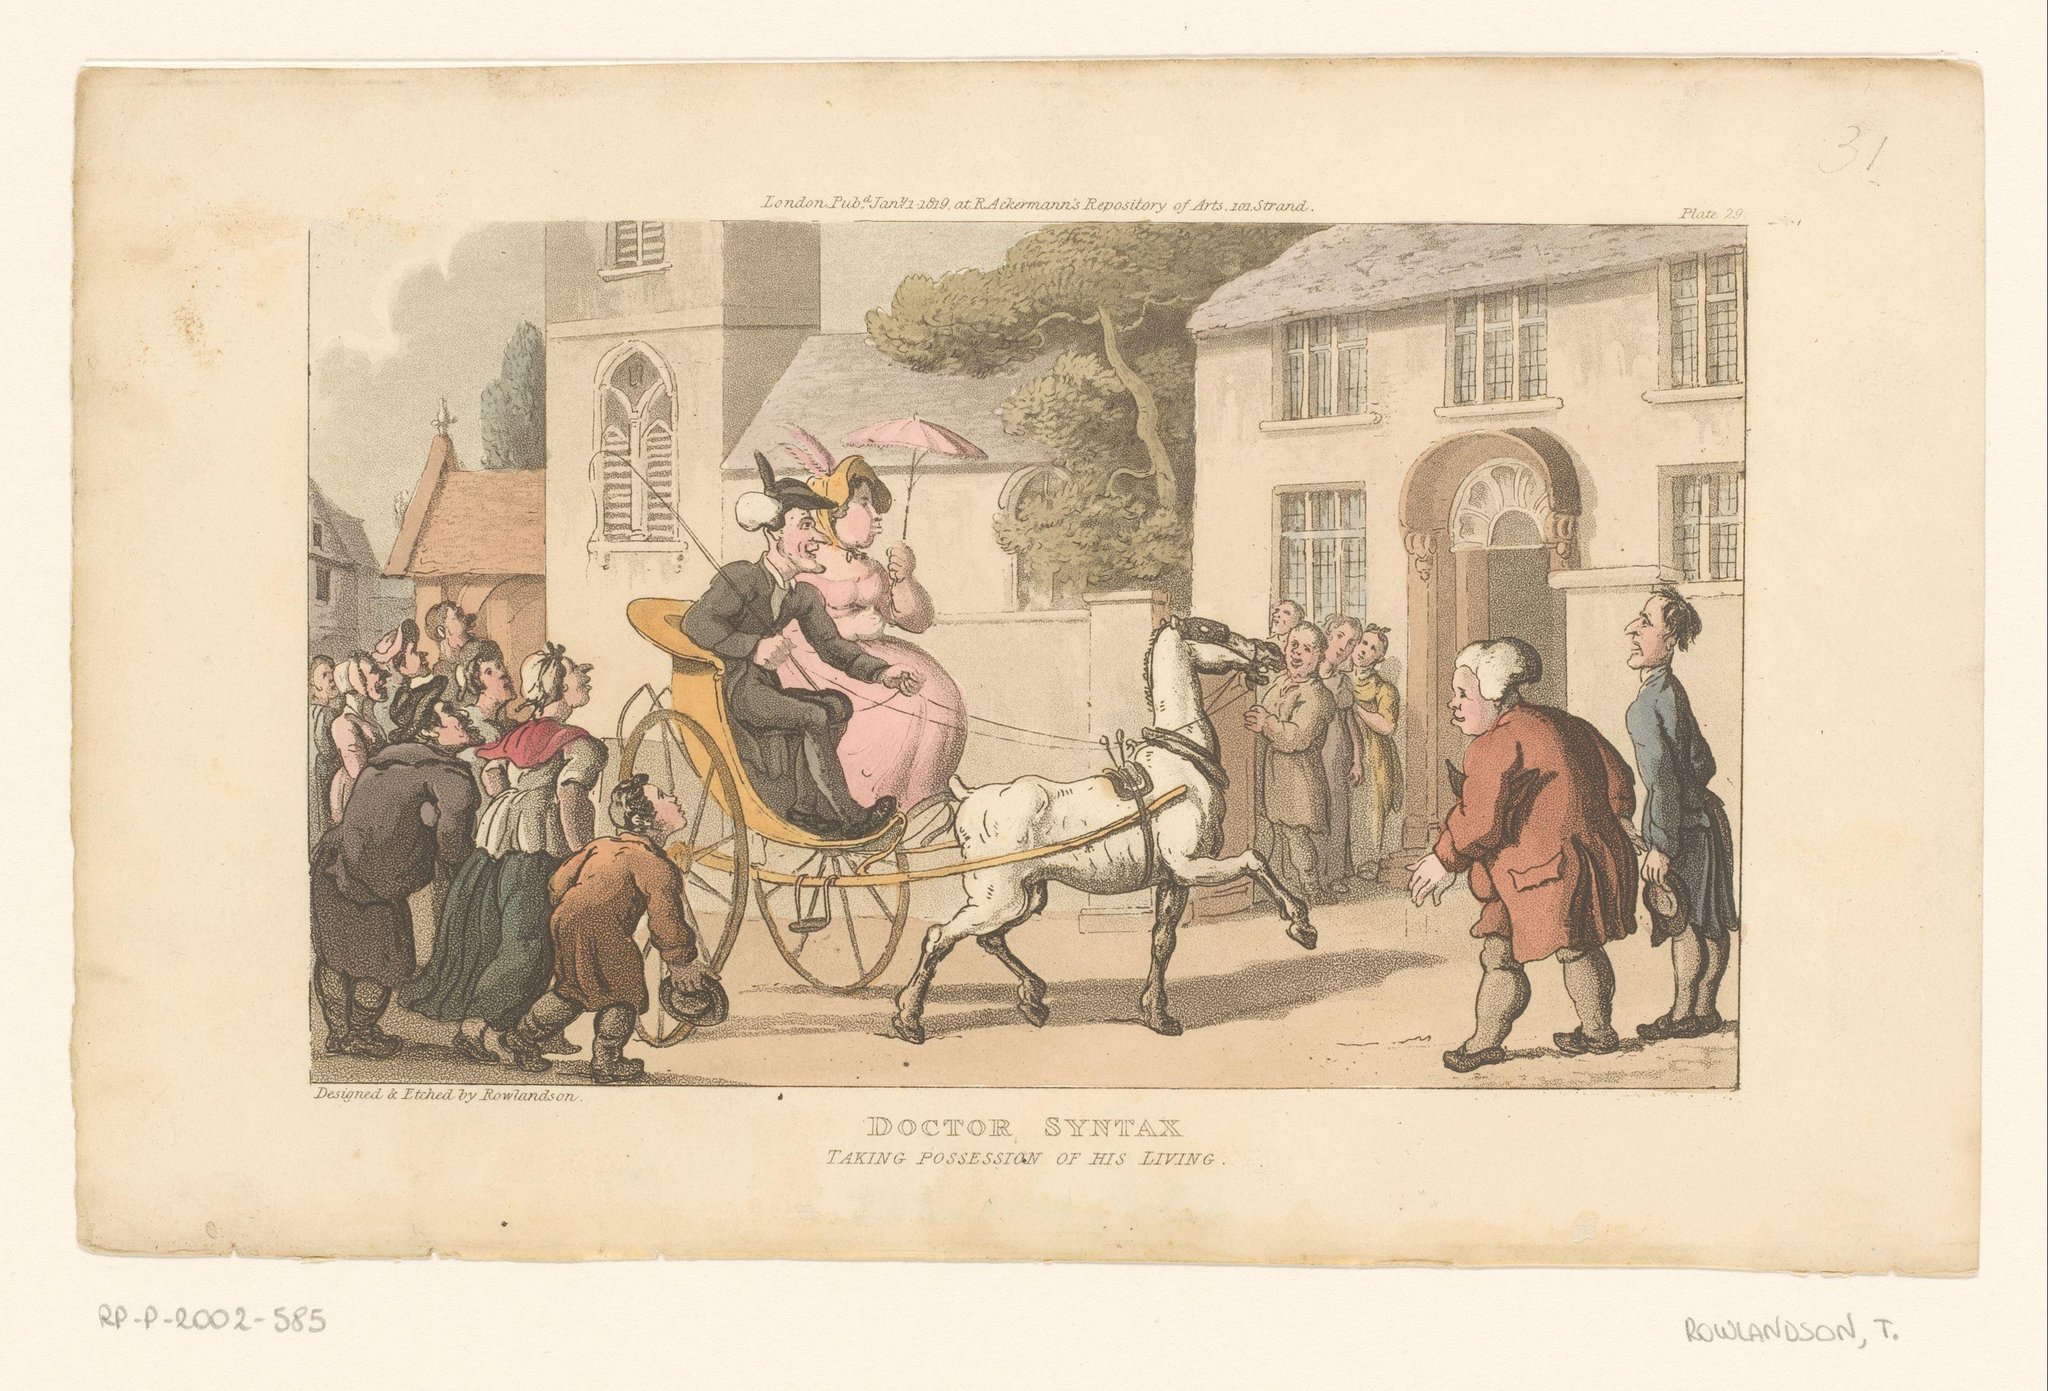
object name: print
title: Doctor Syntax taking possession of his living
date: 1801-1819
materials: paper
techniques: aquatint, etching, hand coloring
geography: london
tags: urban housing, church (exterior), two-wheeled vehicle drawn by one animal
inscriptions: collector's mark: Lugt 2228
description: Prent ook gebruikt in: Combe, William. The Tour of Doctor Syntax, in Search of the Picturesque. A Poem. Londen: Rudolph Ackermann, 1819. Het gedicht is een satire op William Gilpin, die in Groot-Brittannië op zoek ging naar 'het pittoreske'. Het gedicht verscheen voor het eerst met illustraties van Rowlandson in The Poetical Magazine, tussen 1809 en 1811. Voor de editie uit 1819 zijn nieuwe platen gemaakt.